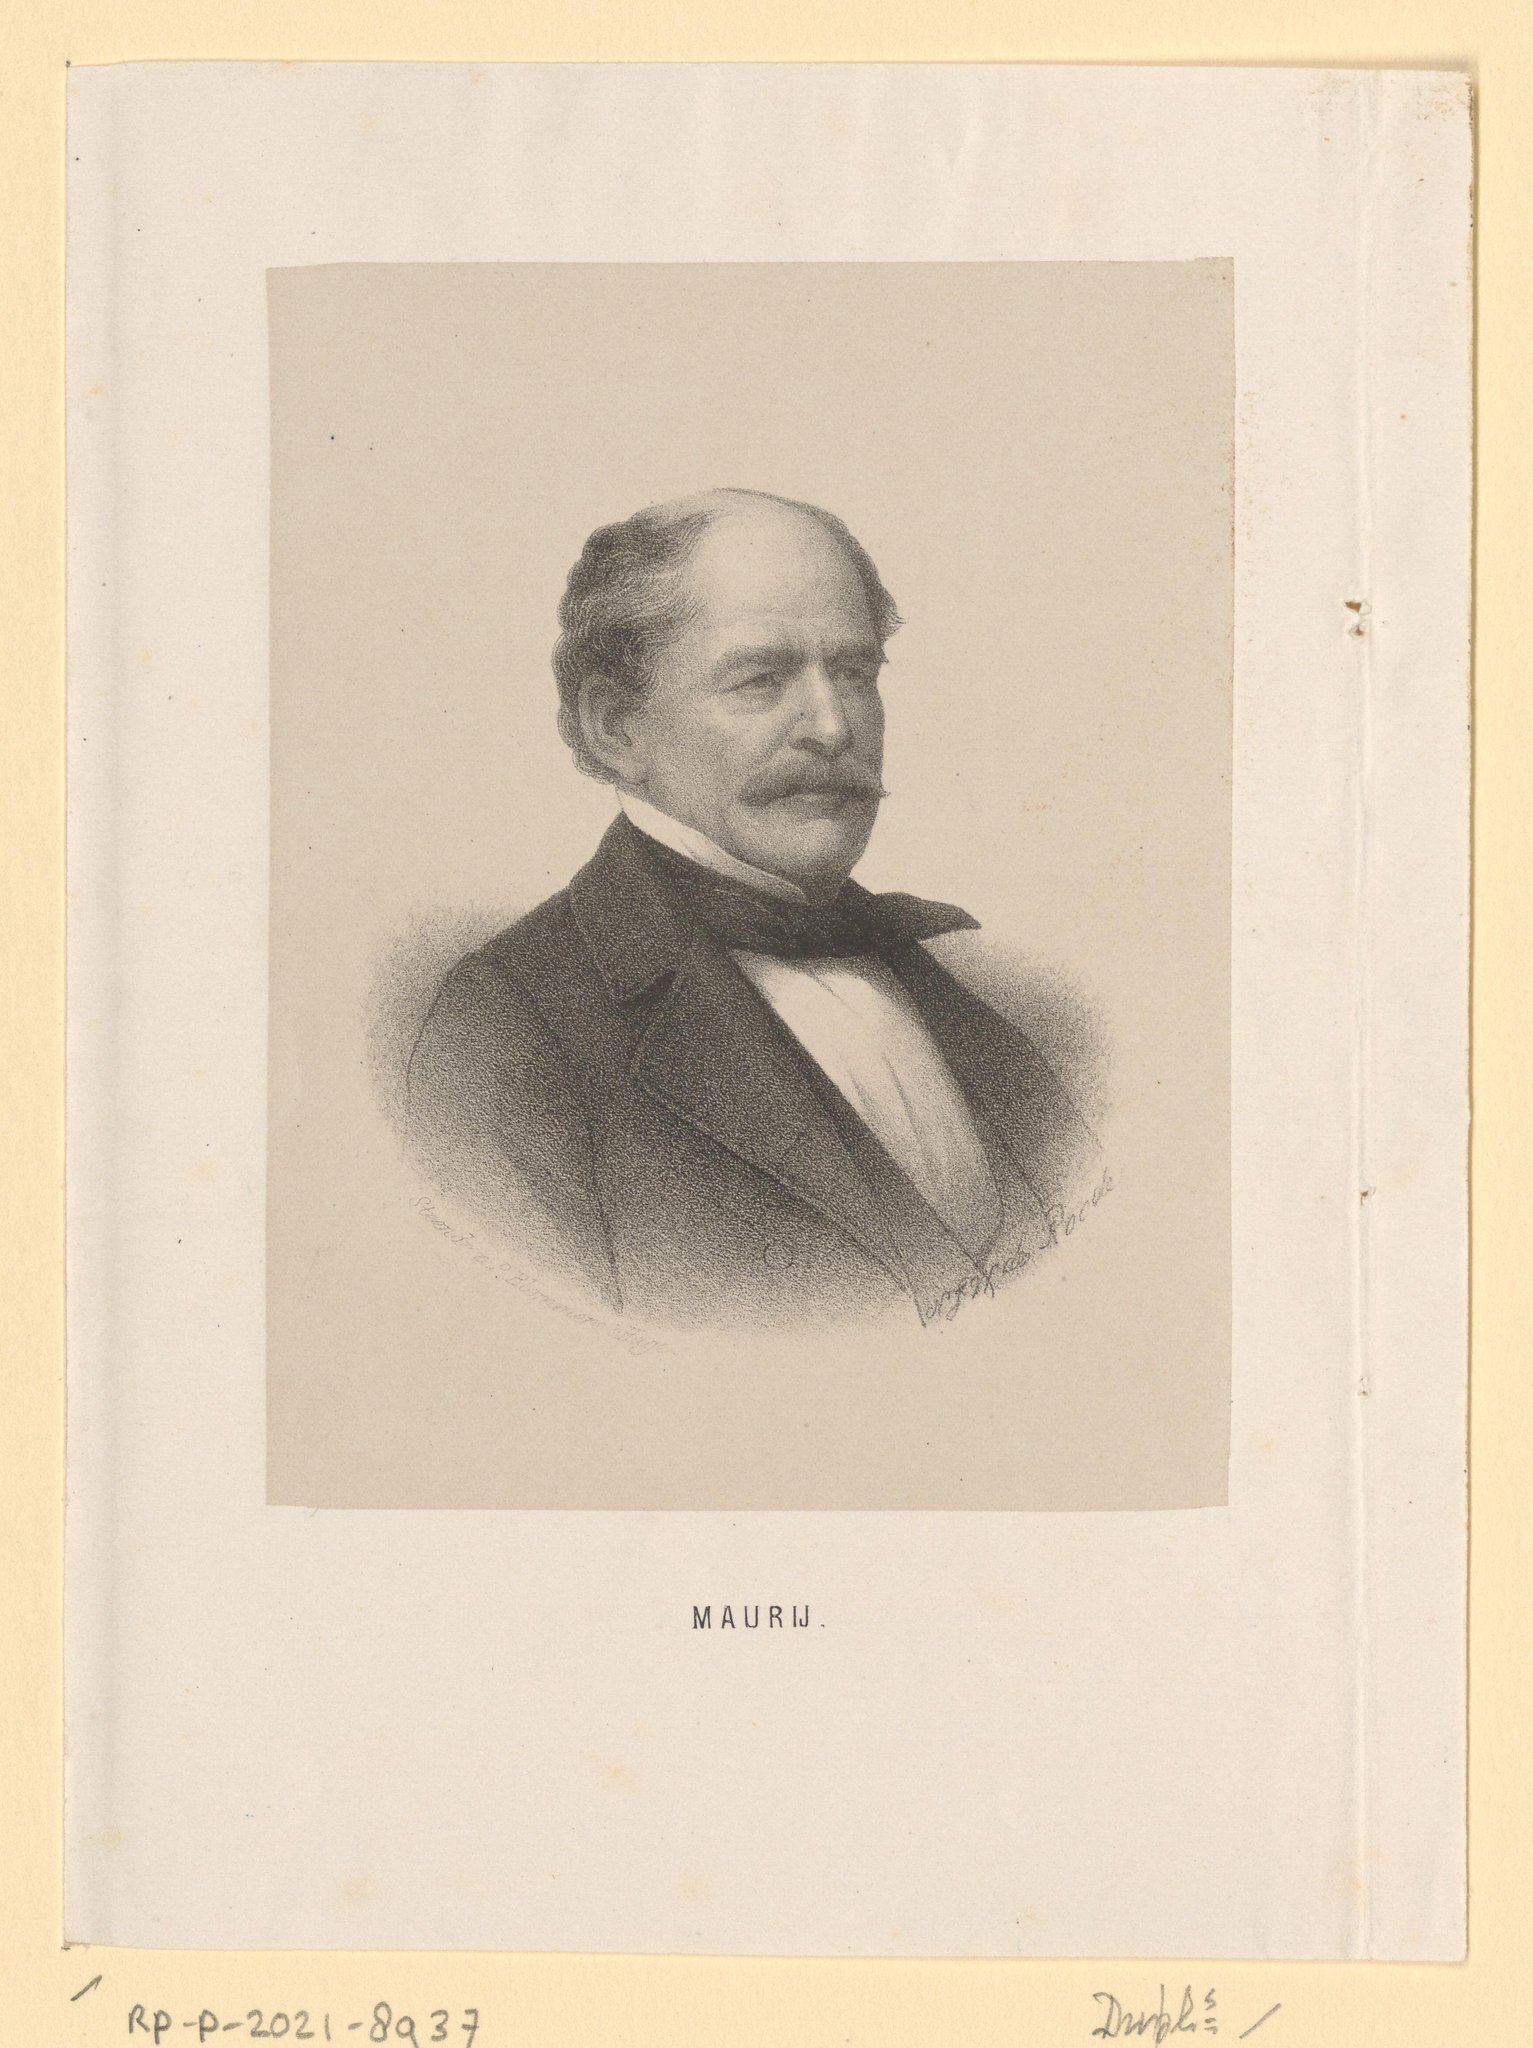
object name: print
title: Portret van Matthew Fontaine Maury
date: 1850-1884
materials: paper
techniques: lithograph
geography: the hague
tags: matthew fontaine maury, astronomy (and cosmography) (+ portrait of scholar, scientist), historical persons